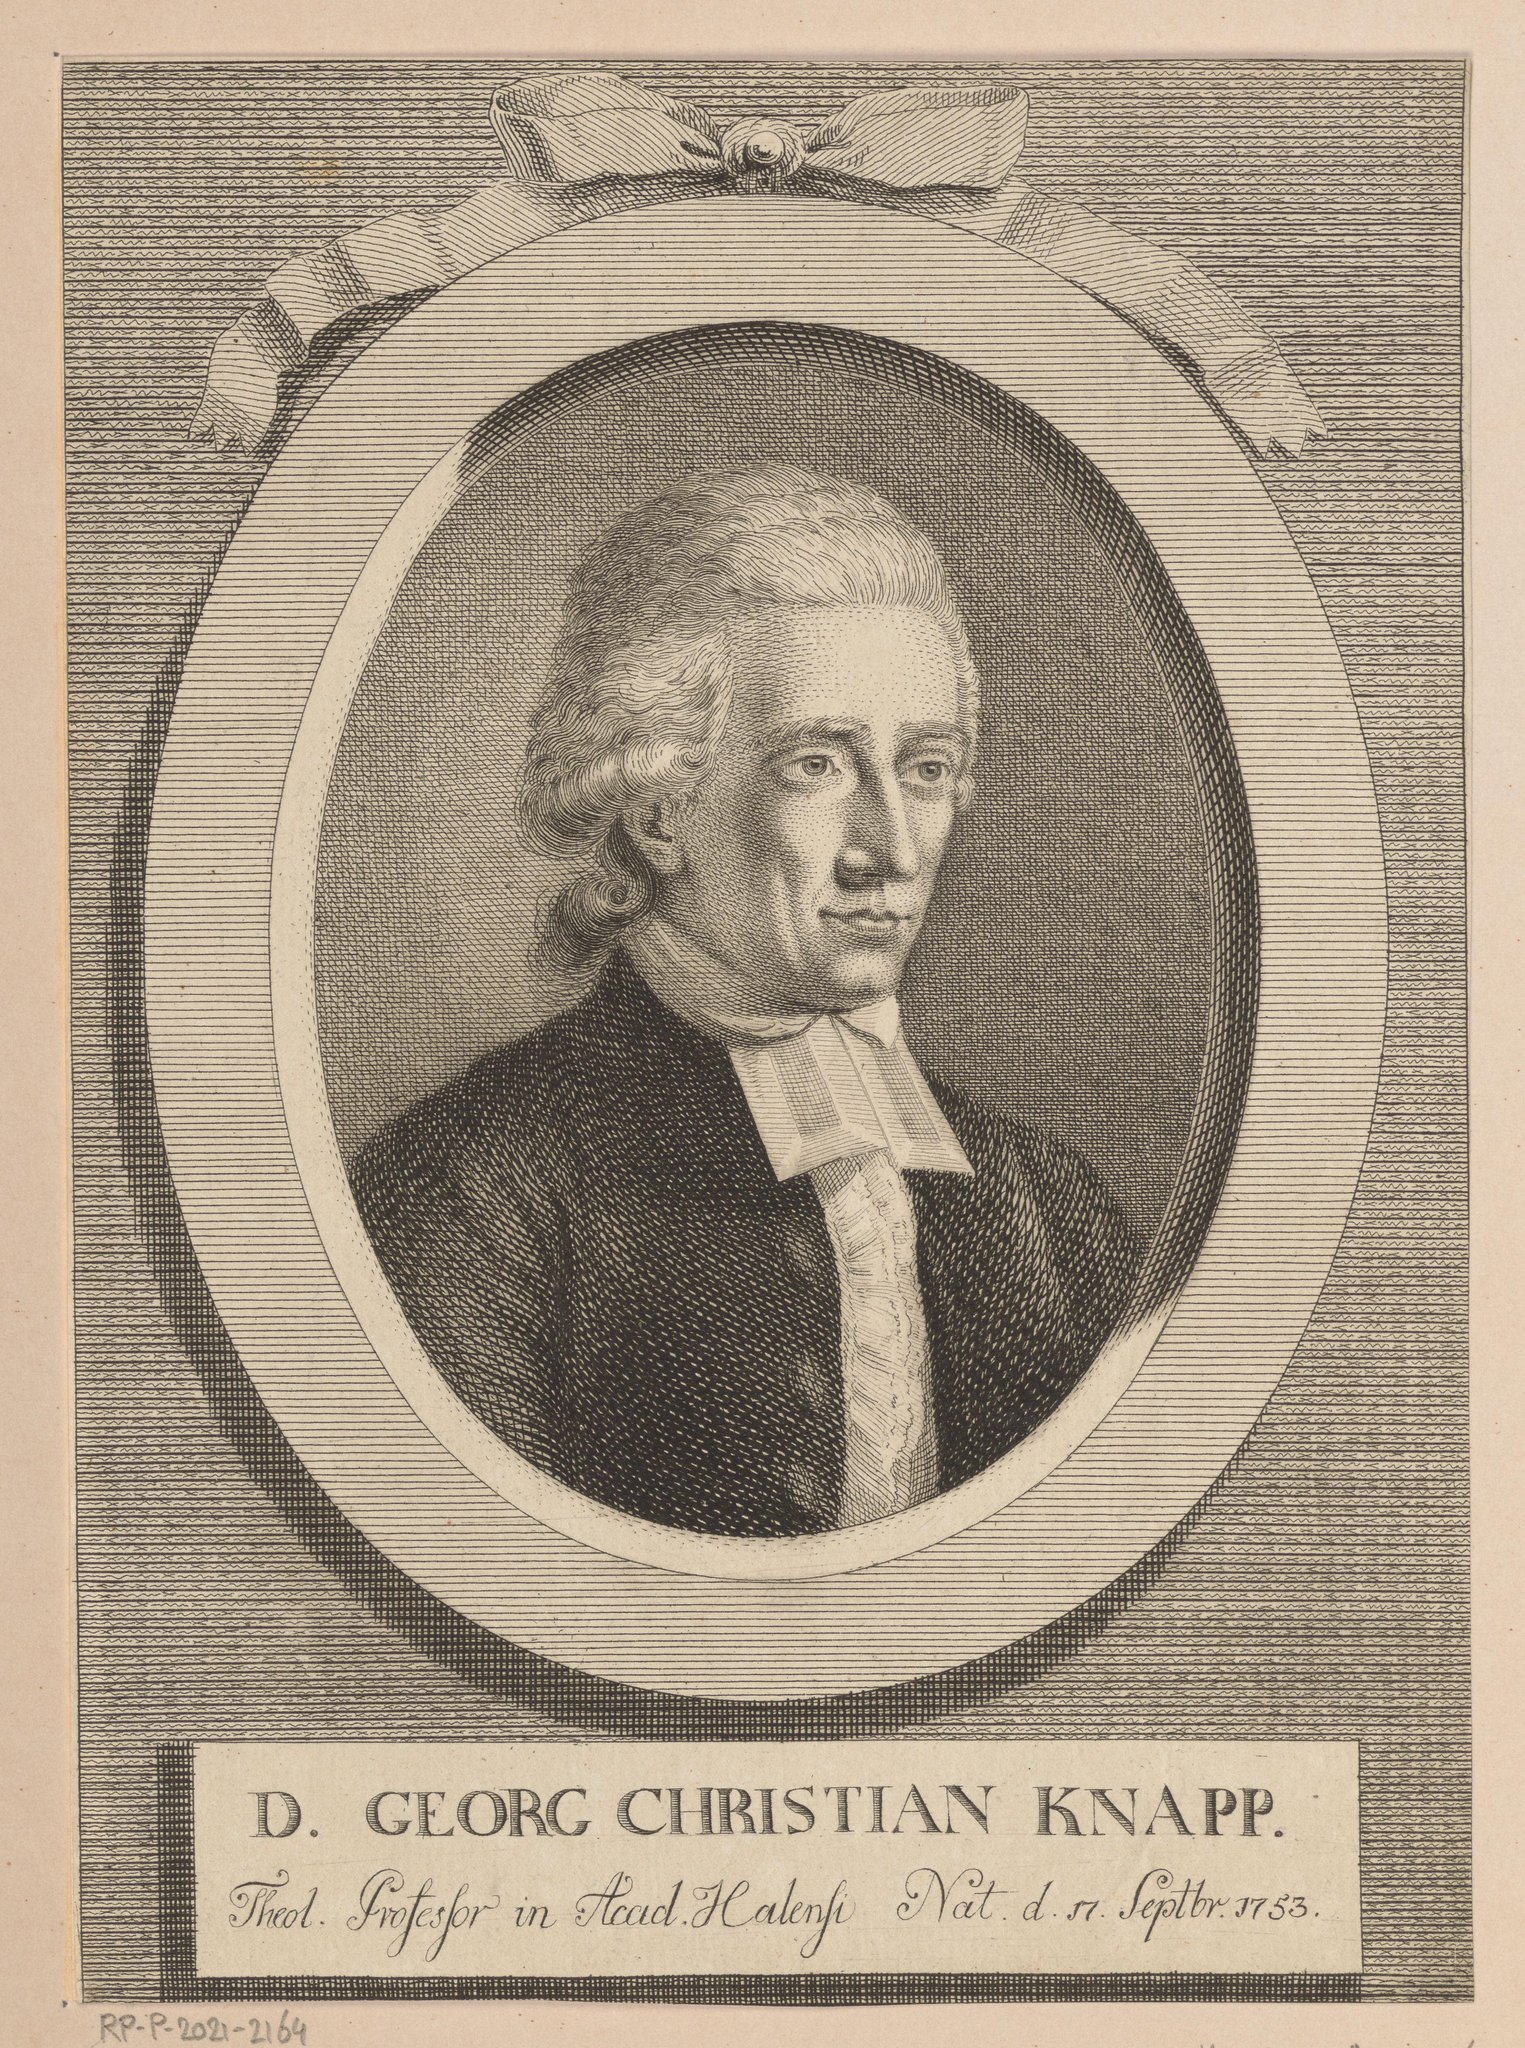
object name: print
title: Portret van Georg Christian Knapp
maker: daniel beyel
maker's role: draughtsman, print maker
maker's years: 1760-1823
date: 1770-1823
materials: paper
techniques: engraving, etching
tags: historical persons